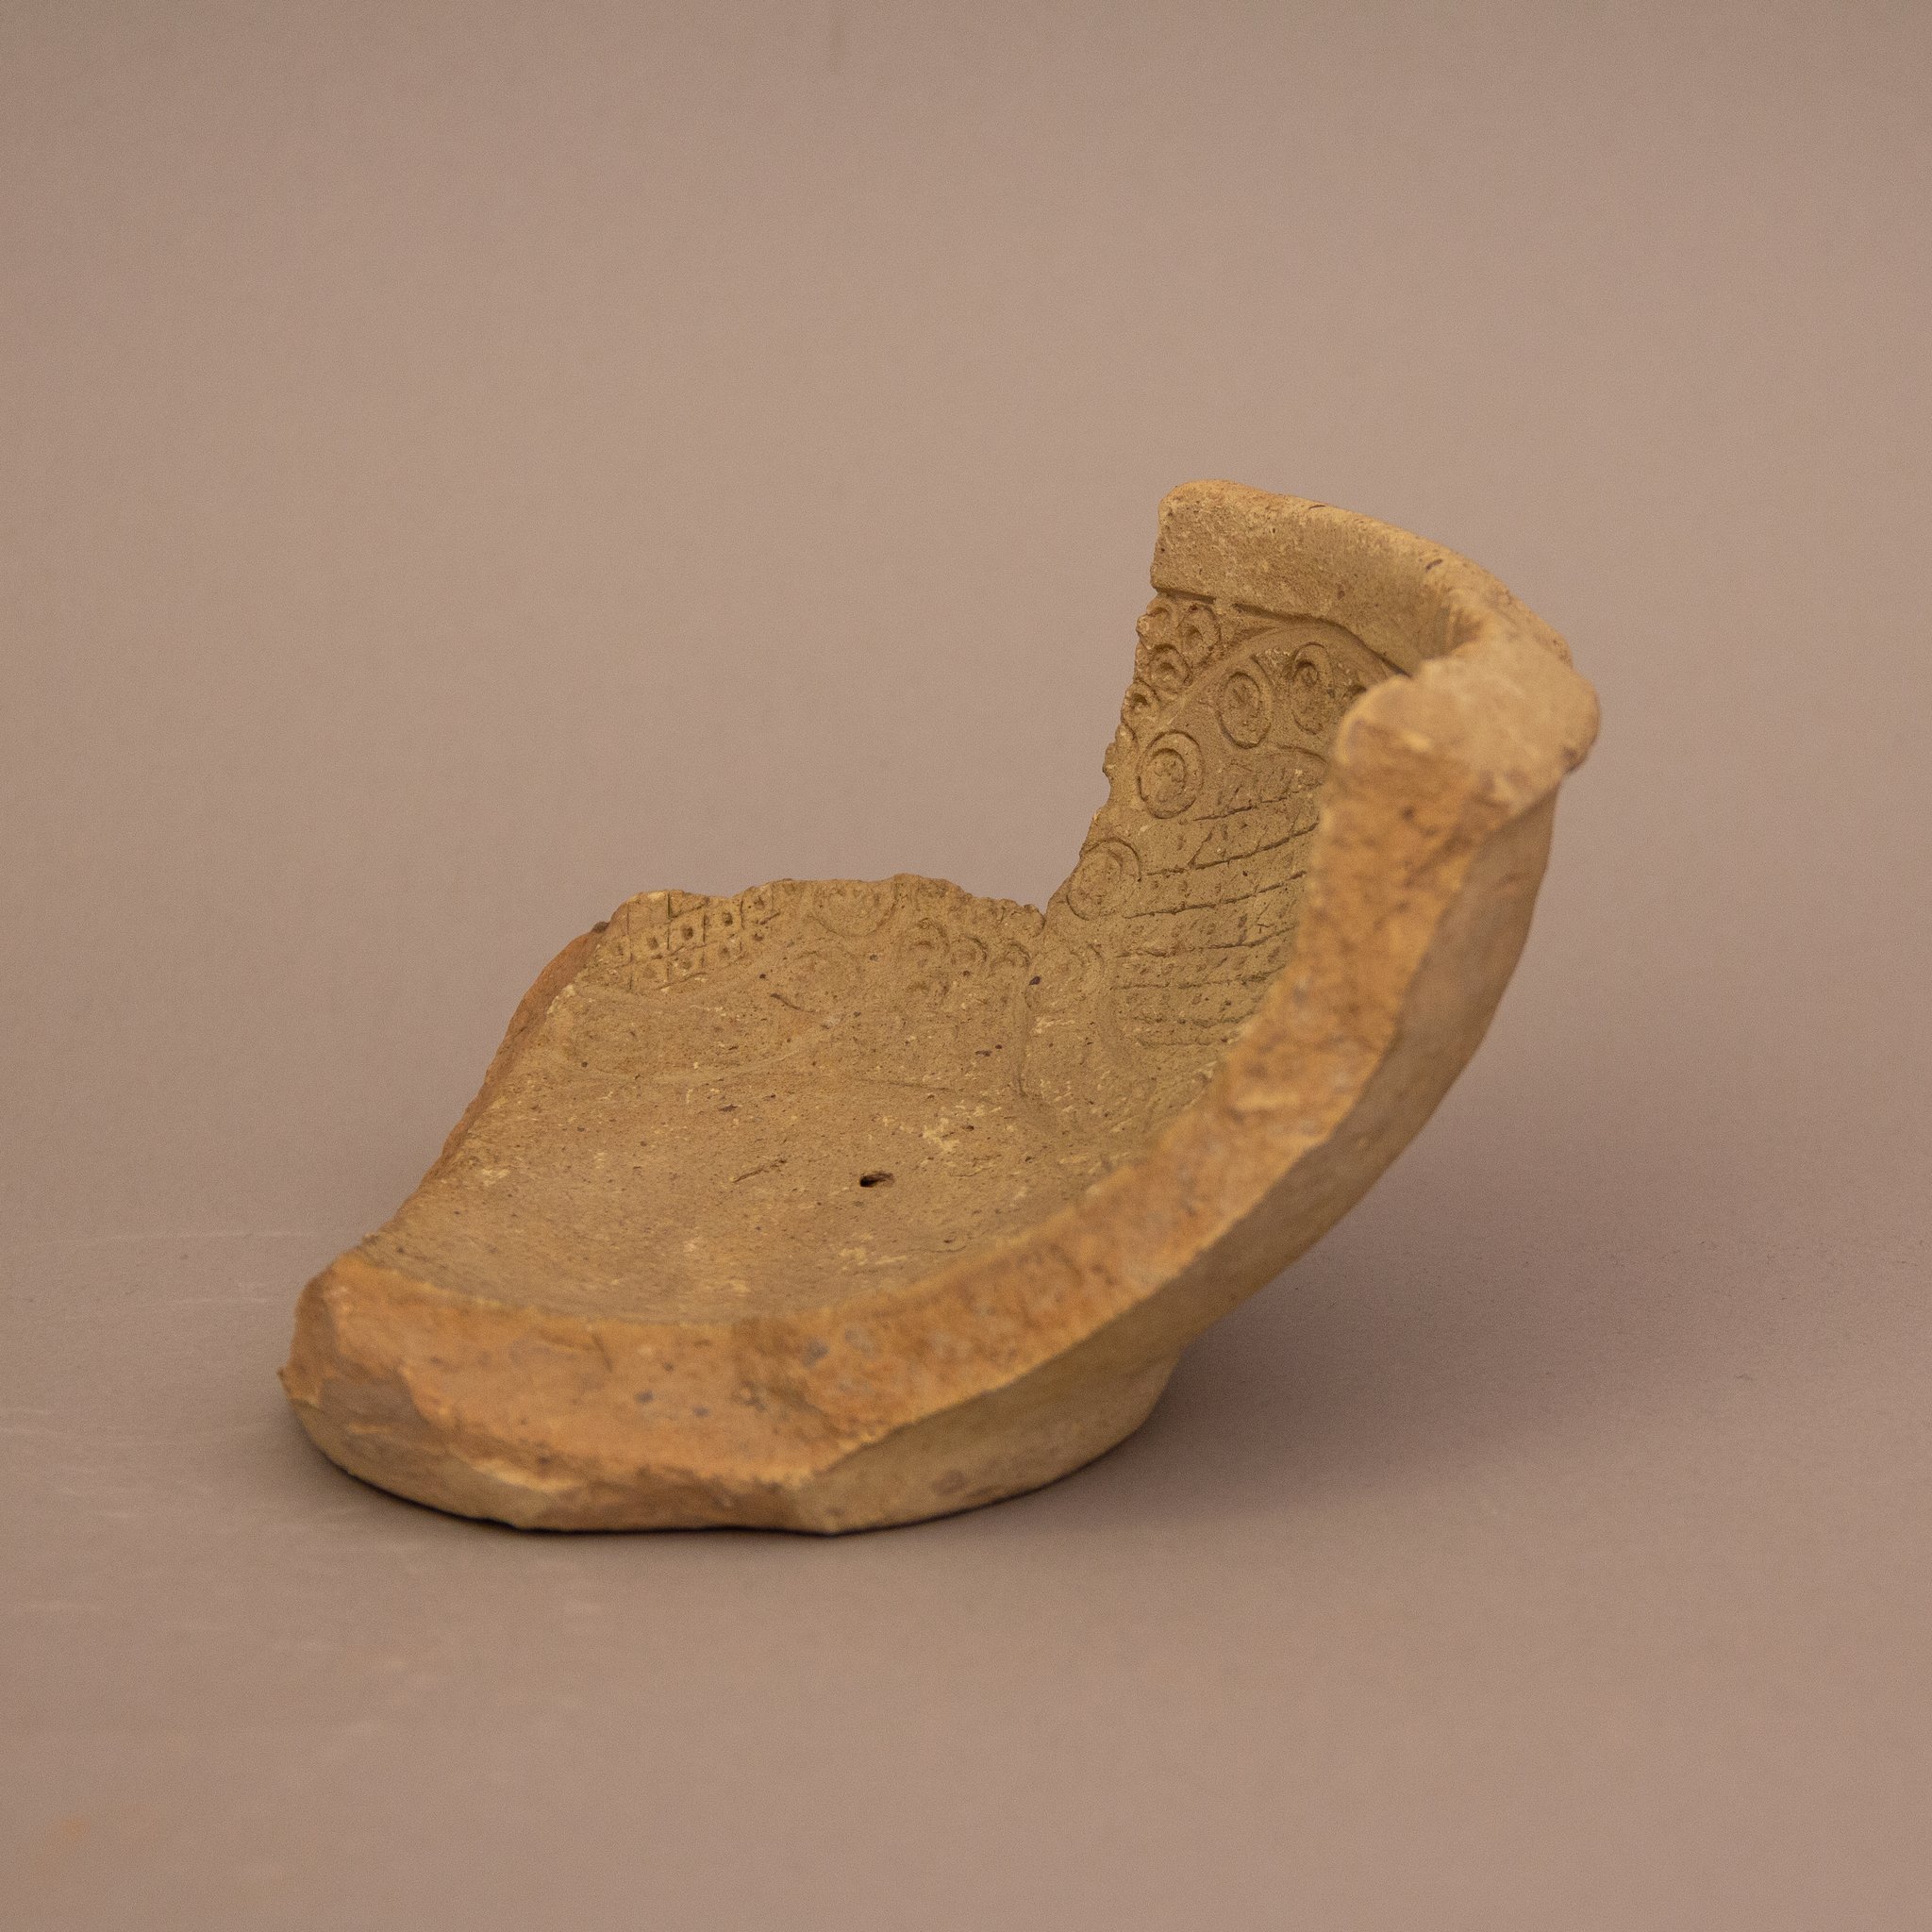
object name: mold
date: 767-900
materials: earthenware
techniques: incising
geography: iran